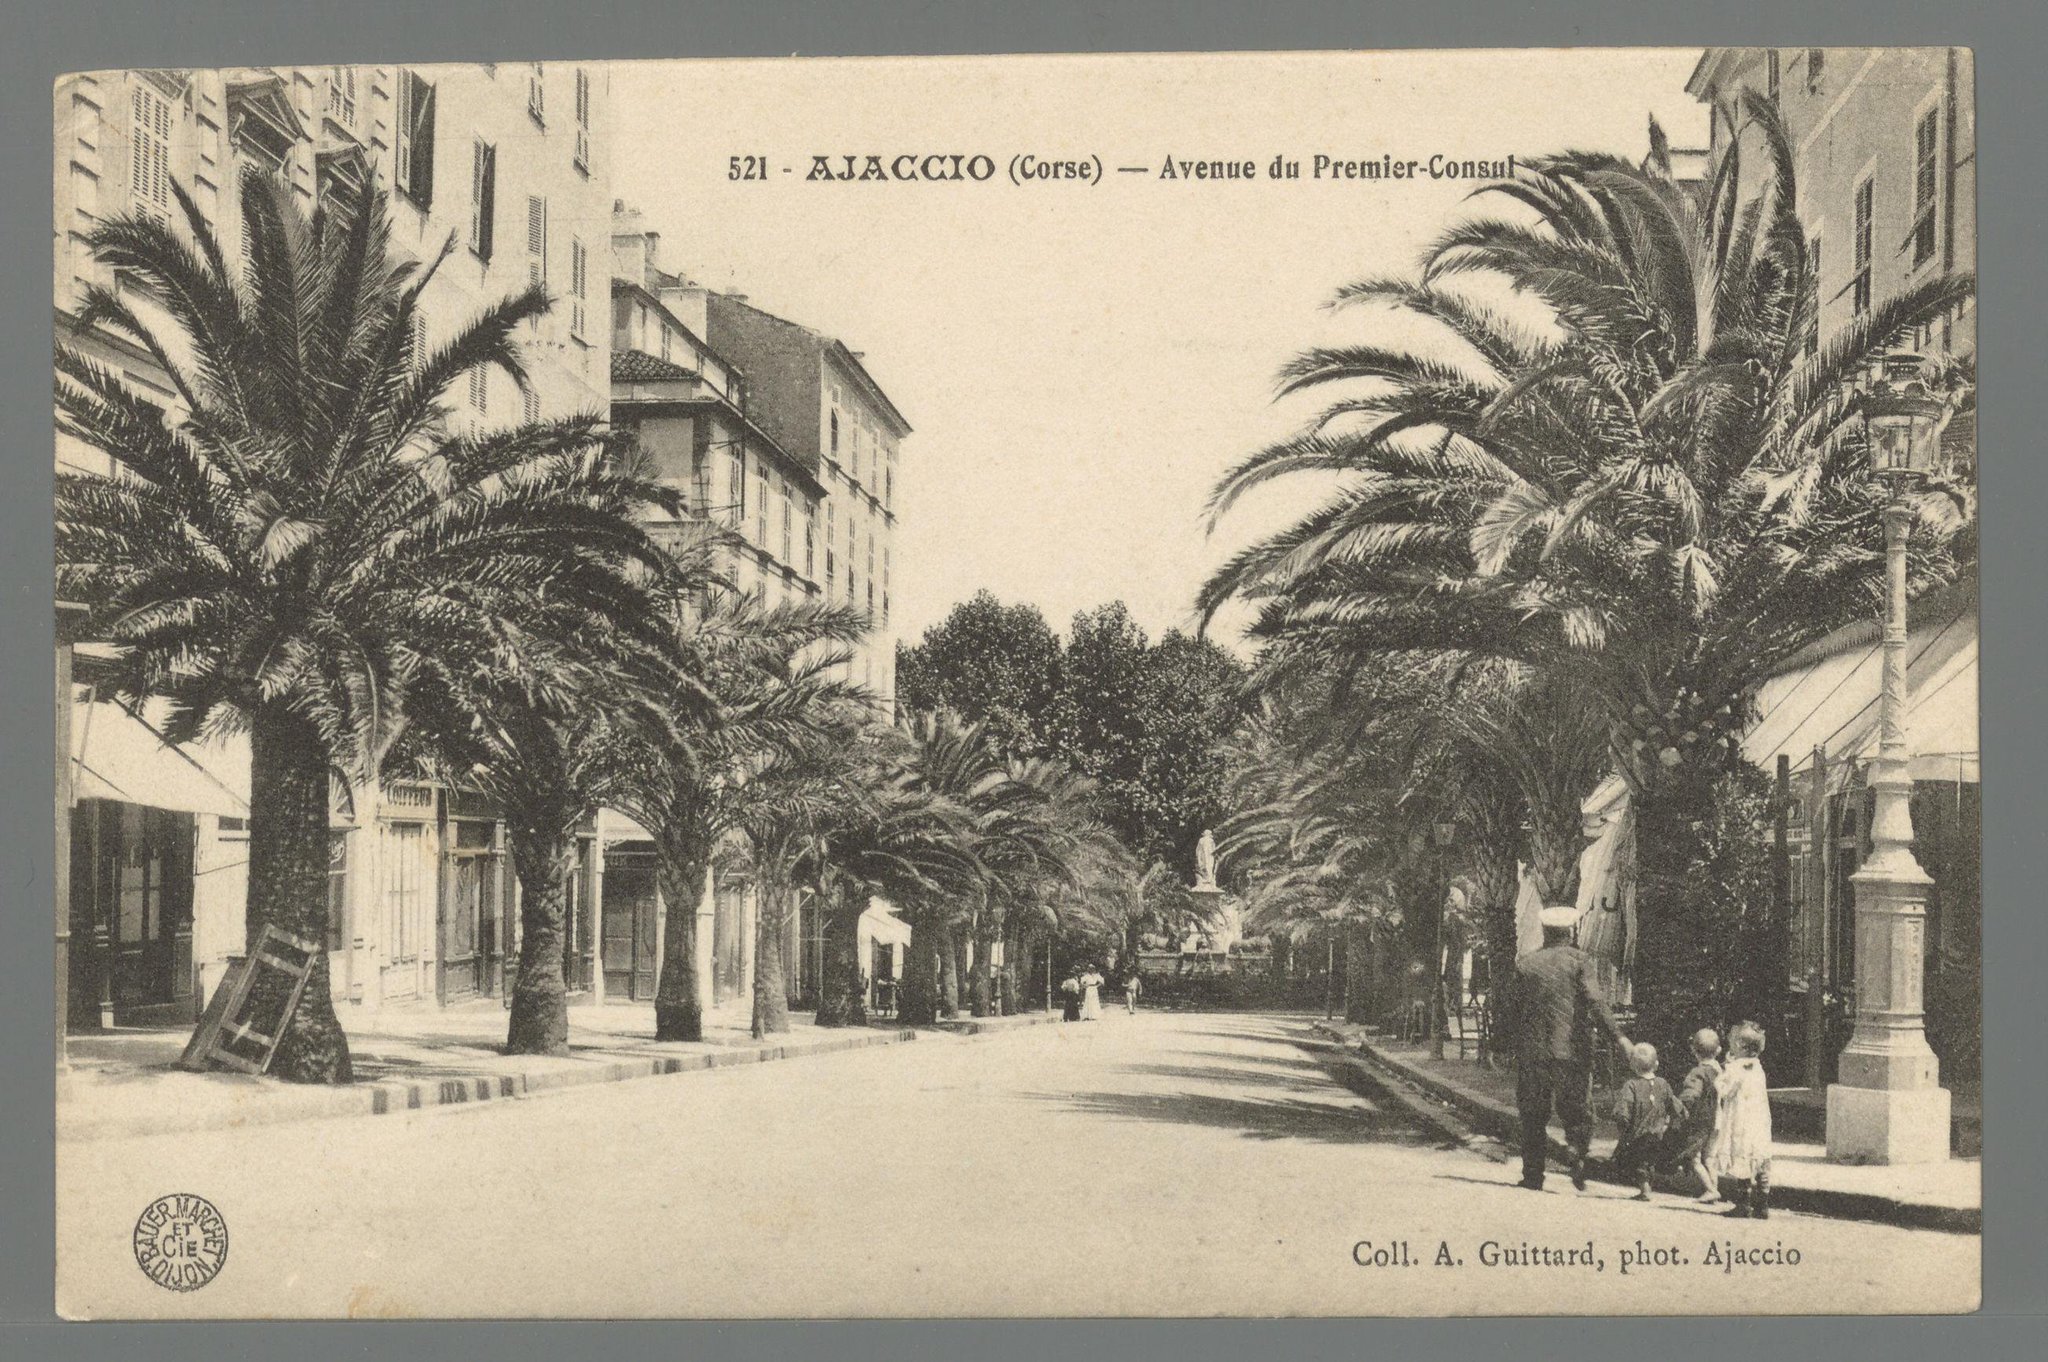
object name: photomechanical print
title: Ajaccio (Corse). Avenue du Premier-Consul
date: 1904-1906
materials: cardboard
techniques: photograph, writing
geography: dijon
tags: avenue, boulevard, promenade, esplanade (+ city(-scape) with figures, staffage), trees: palm-tree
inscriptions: postage stamp